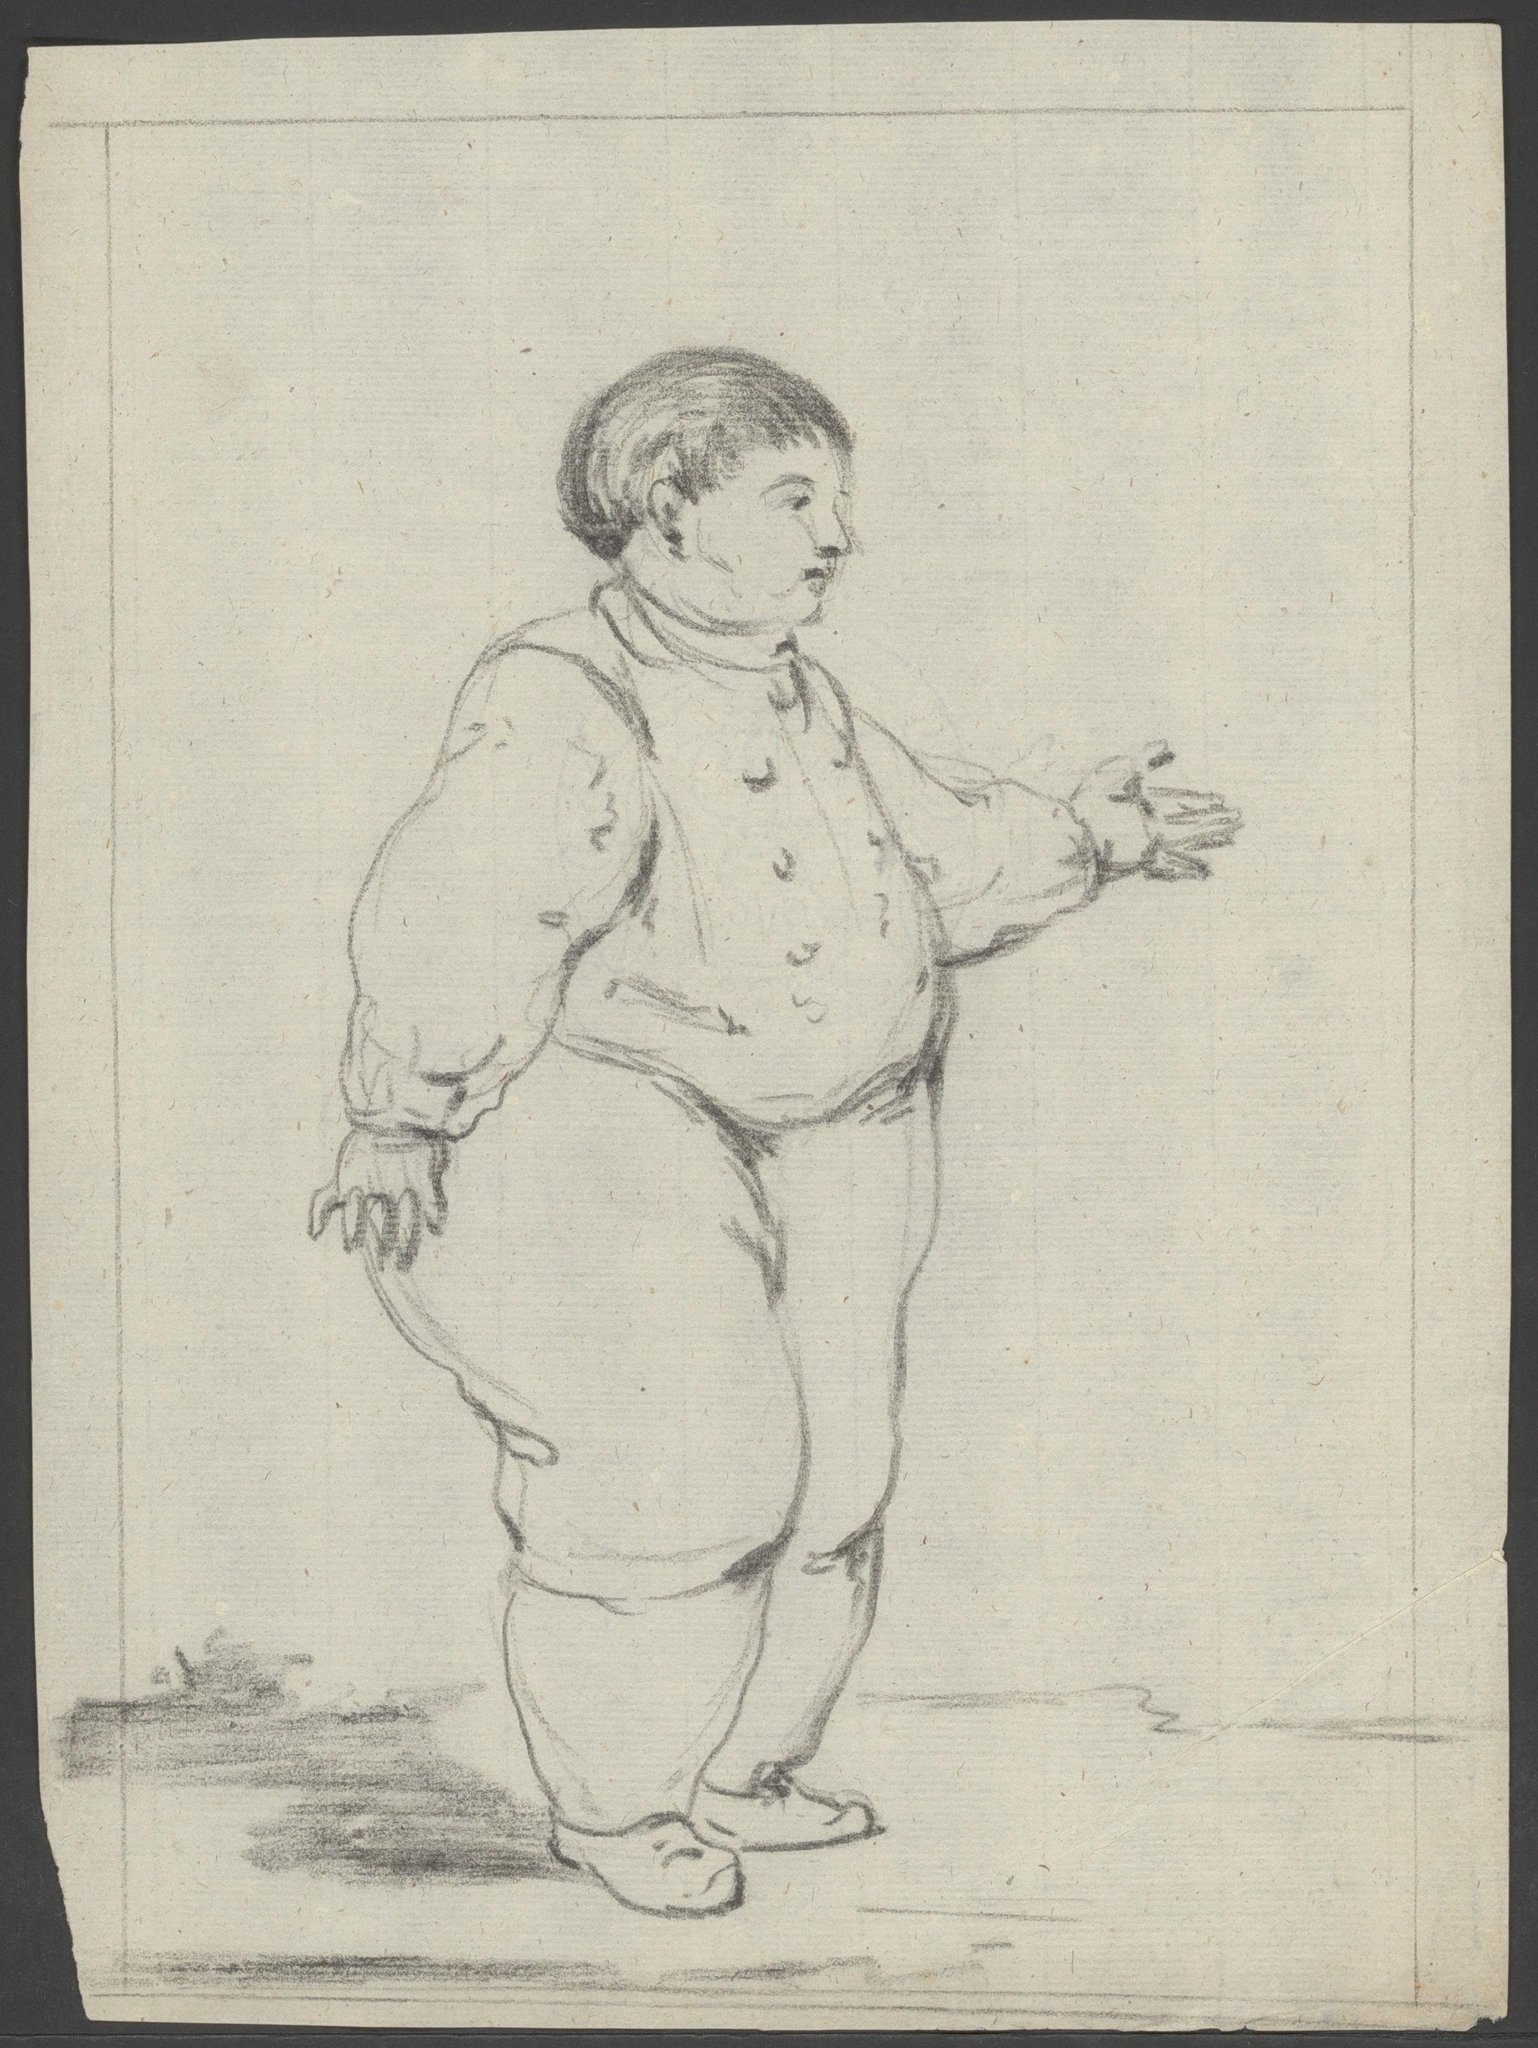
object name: drawing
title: Staande jonge man met opgestoken hand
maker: Anonymous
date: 1800-1899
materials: chalk, paper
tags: standing figure, fat (human type)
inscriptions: stamp, collector's mark: Lugt 1641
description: Onderwerpsrubrieken binnen de Atlas Zeden en Gewoonten: Schoone kunsten, Schilderkunst, Tekeningen.